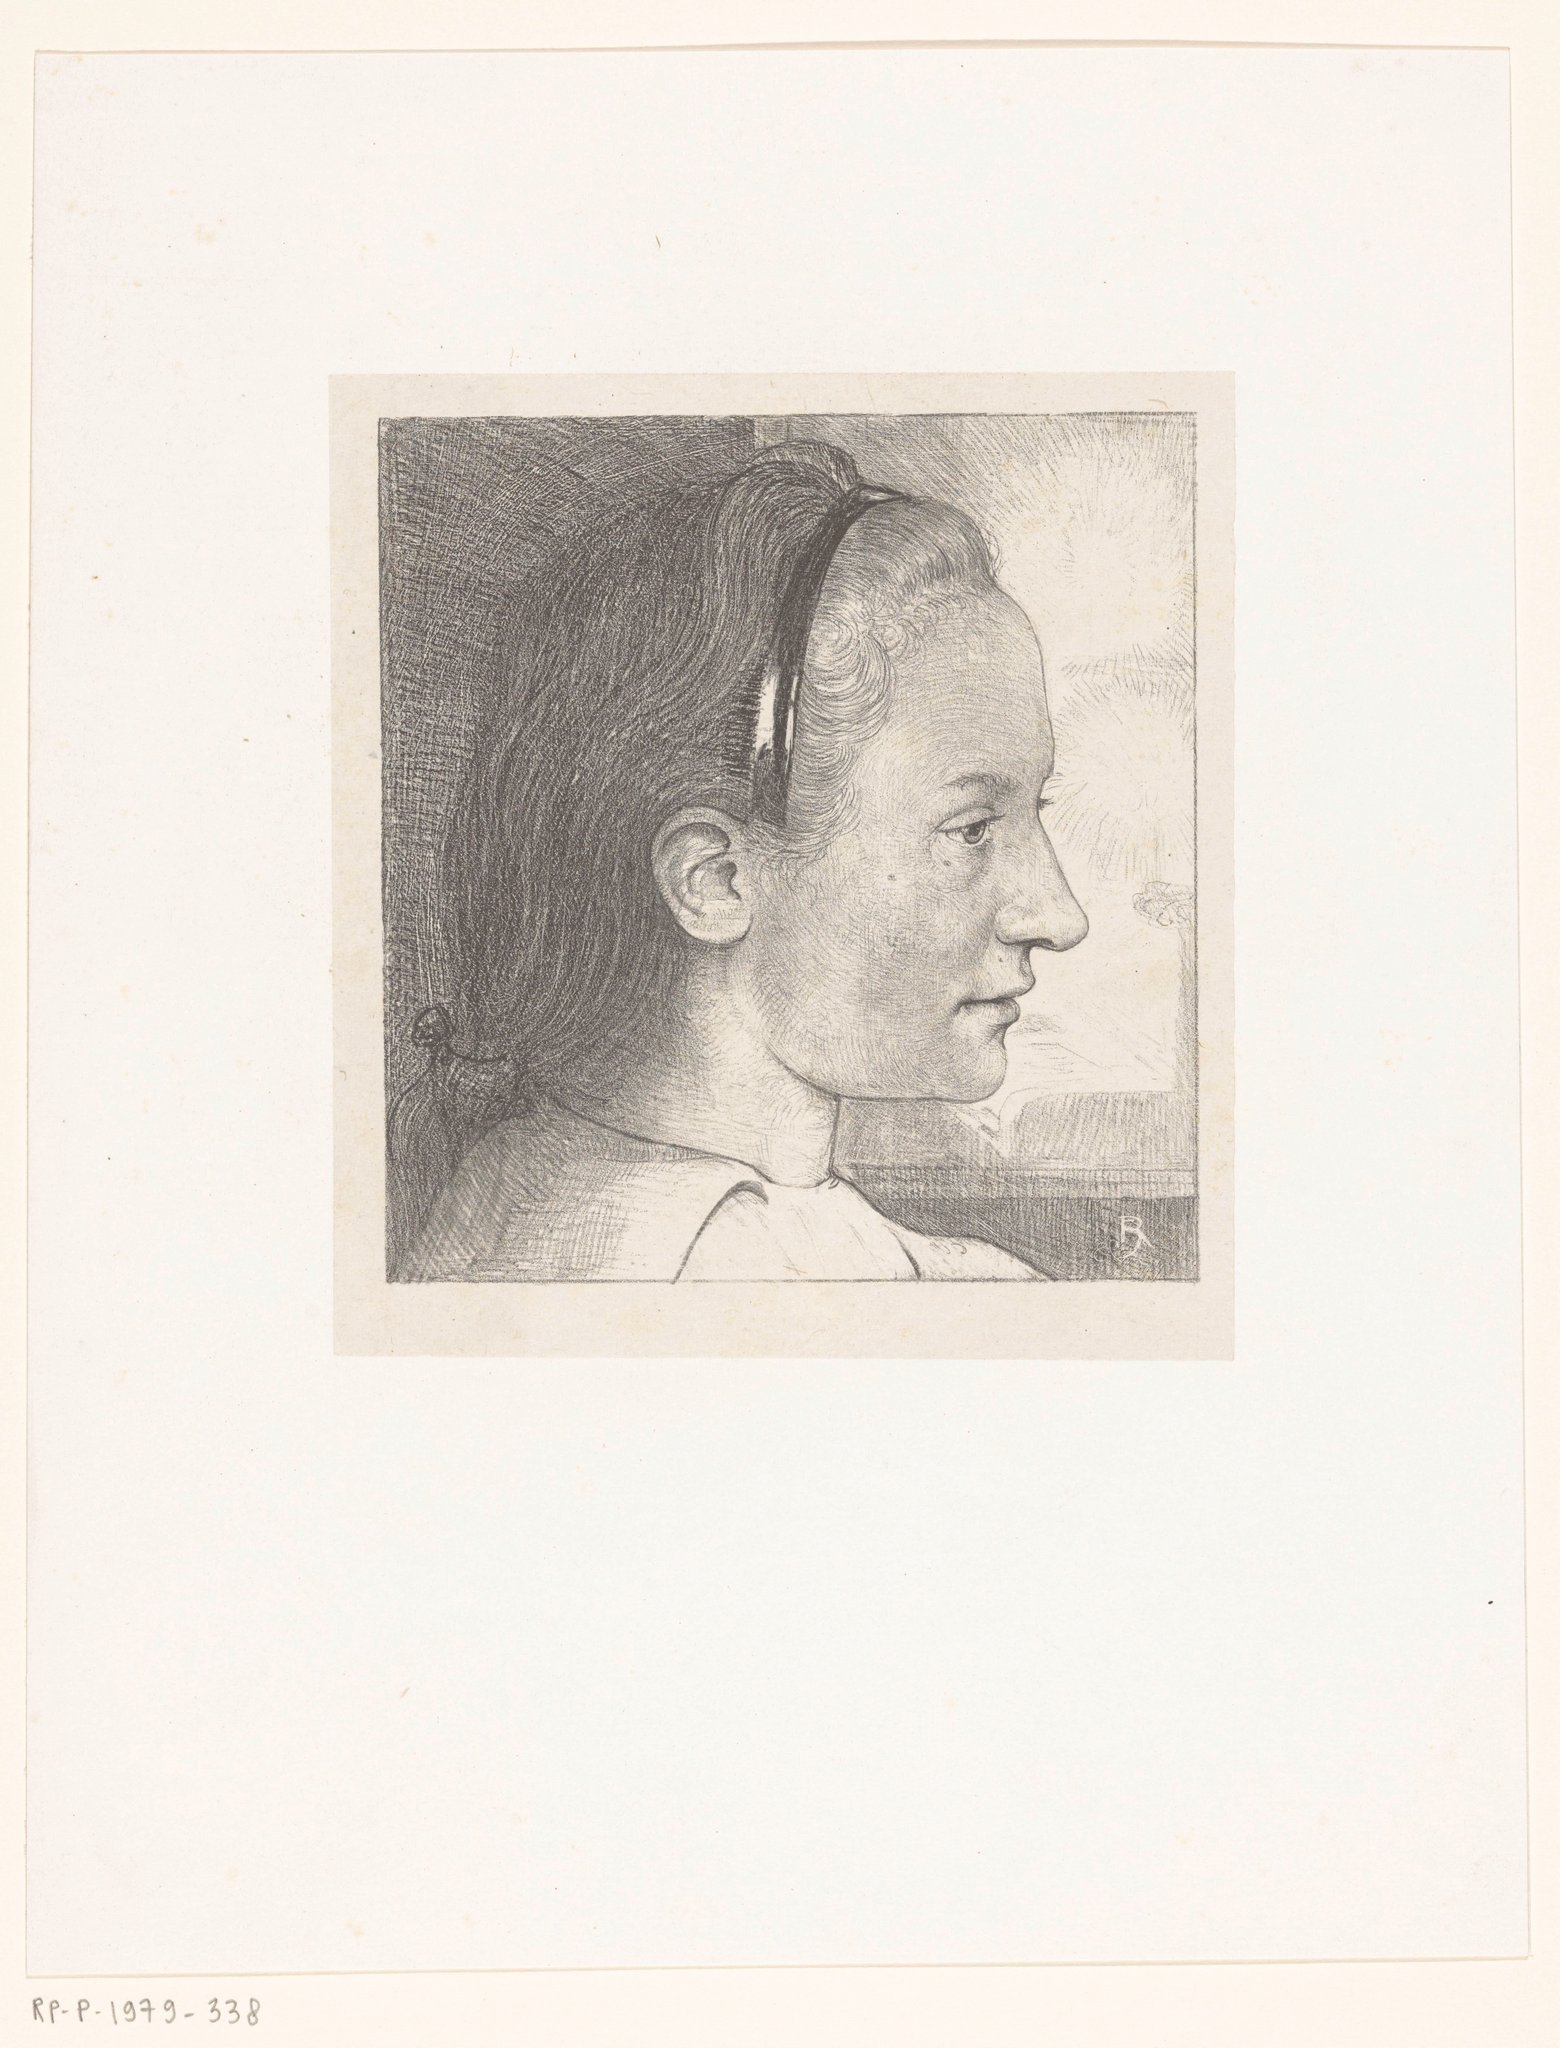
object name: print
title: Portret van Heleen Burgers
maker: richard nicolaüs roland holst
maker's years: 1868-1938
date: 1898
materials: paper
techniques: lithograph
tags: historical persons - bb - woman, child (at home) - aa - girl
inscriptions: collector's mark: Lugt 2228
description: Heleen Burgers was de dochter van Petrus Burgers en Sabine Roland Holst, die een zus was van Richard Roland Holst.